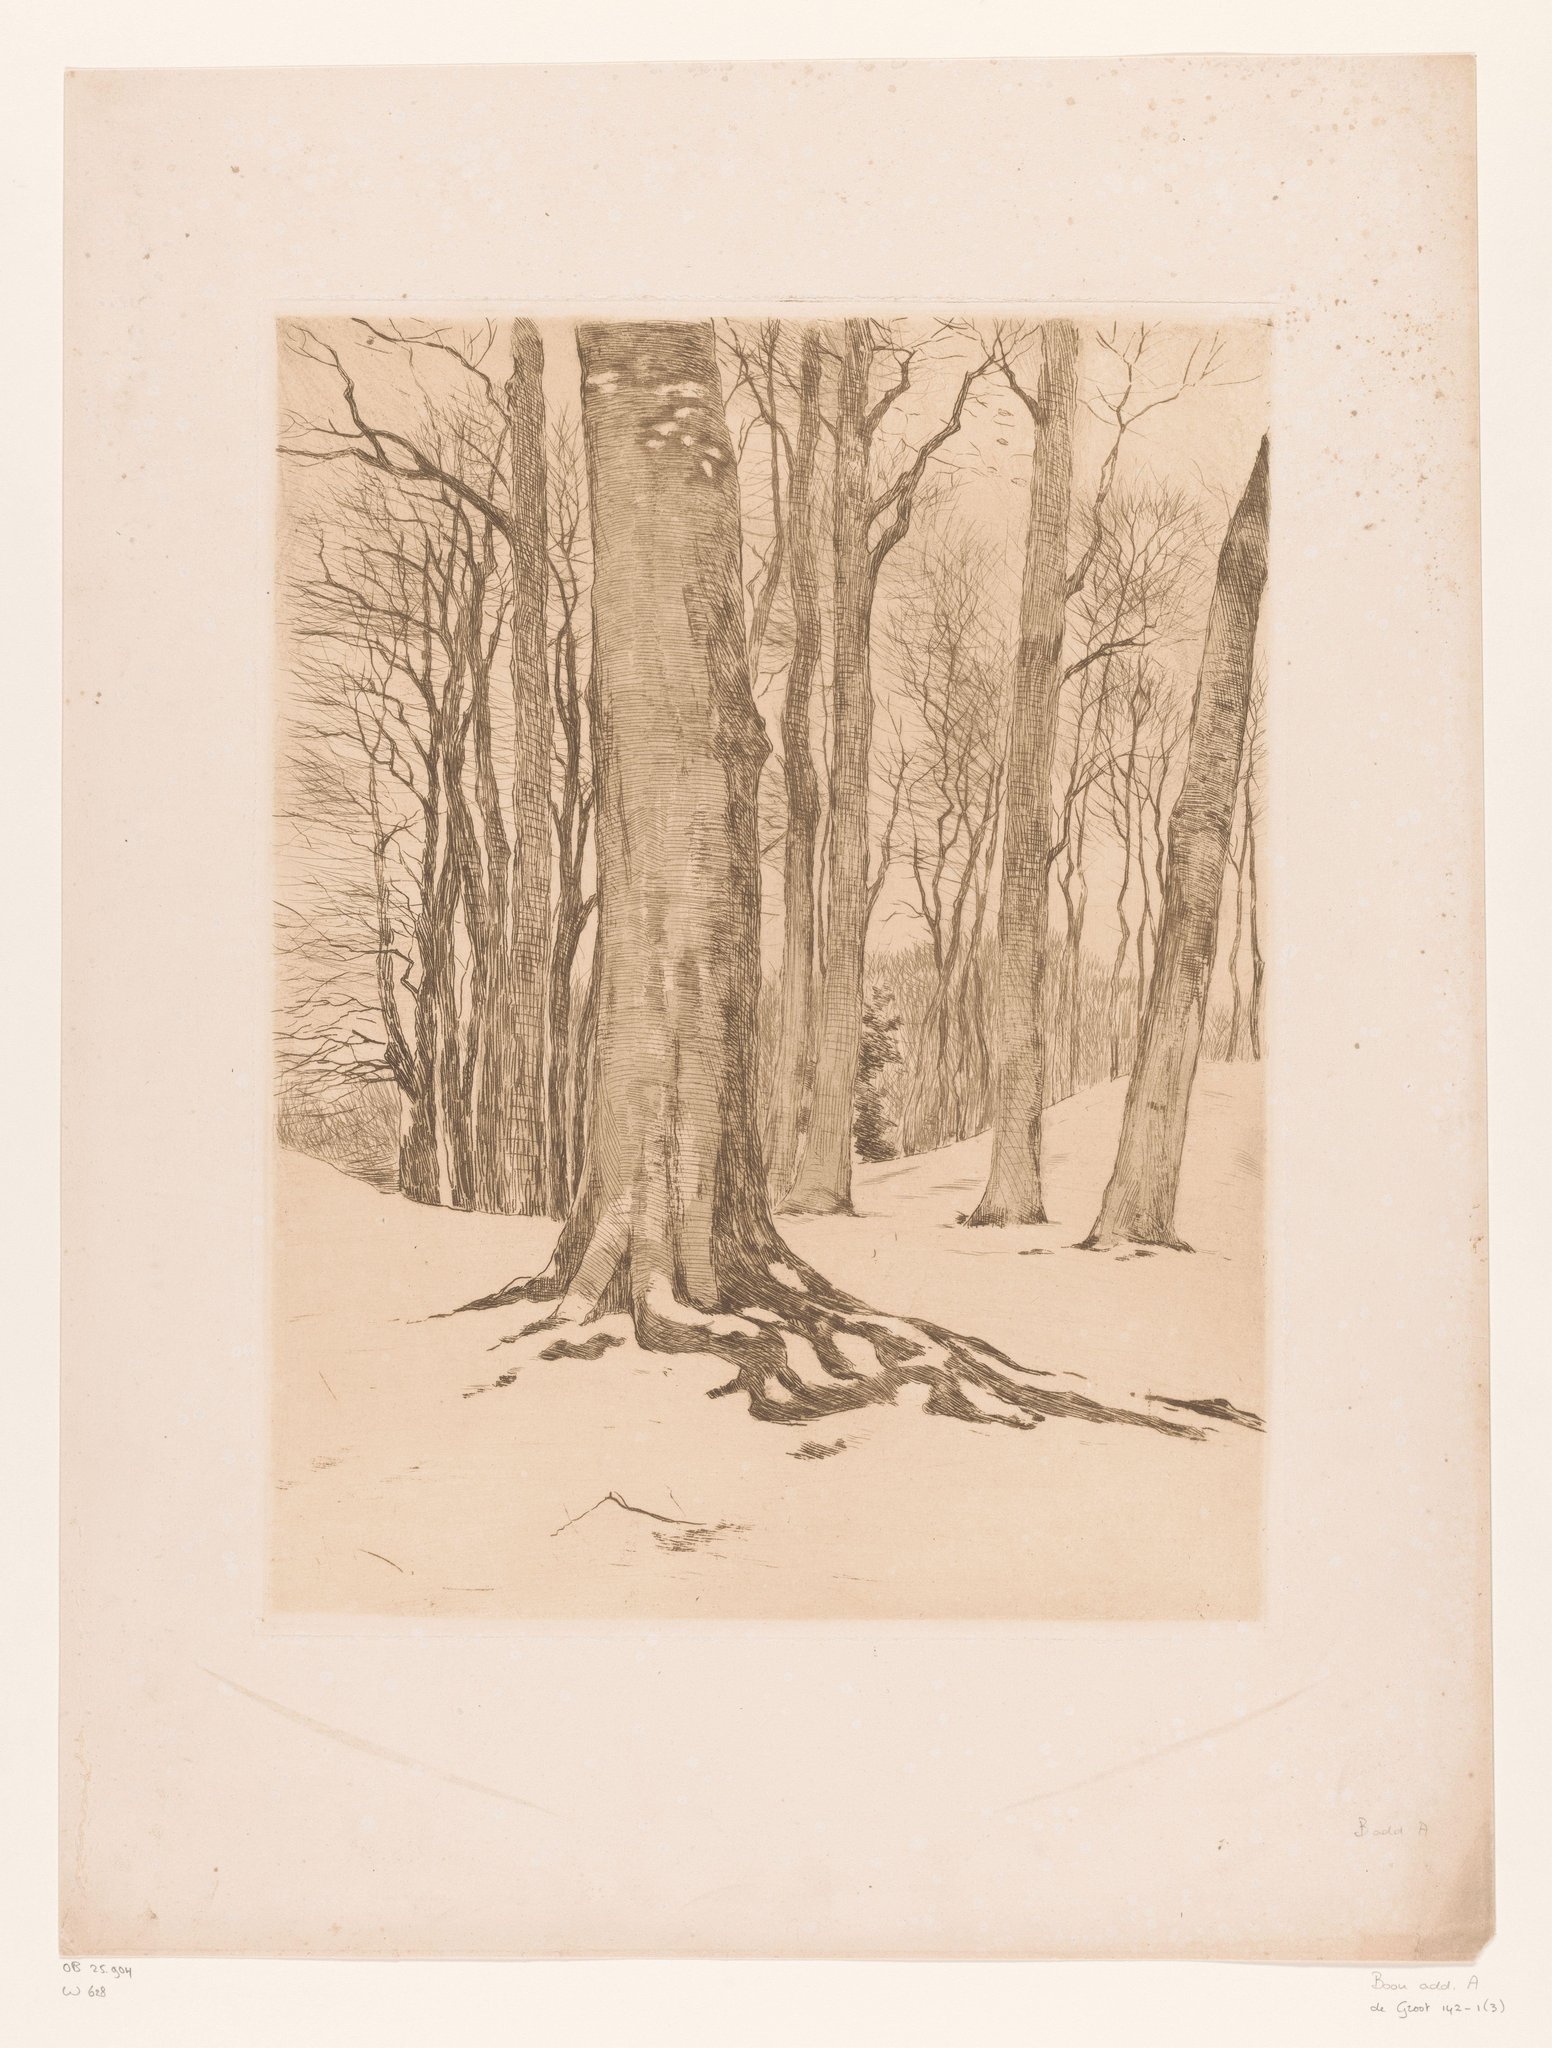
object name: print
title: Besneeuwd bos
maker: willem witsen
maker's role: draughtsman, painter, print maker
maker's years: 1860-1923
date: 1906-1908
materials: paper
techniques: aquatint, etching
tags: forest, wood, snow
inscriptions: annotation: ‘14a/ 14-7-'78 [in getekende driehoek]’